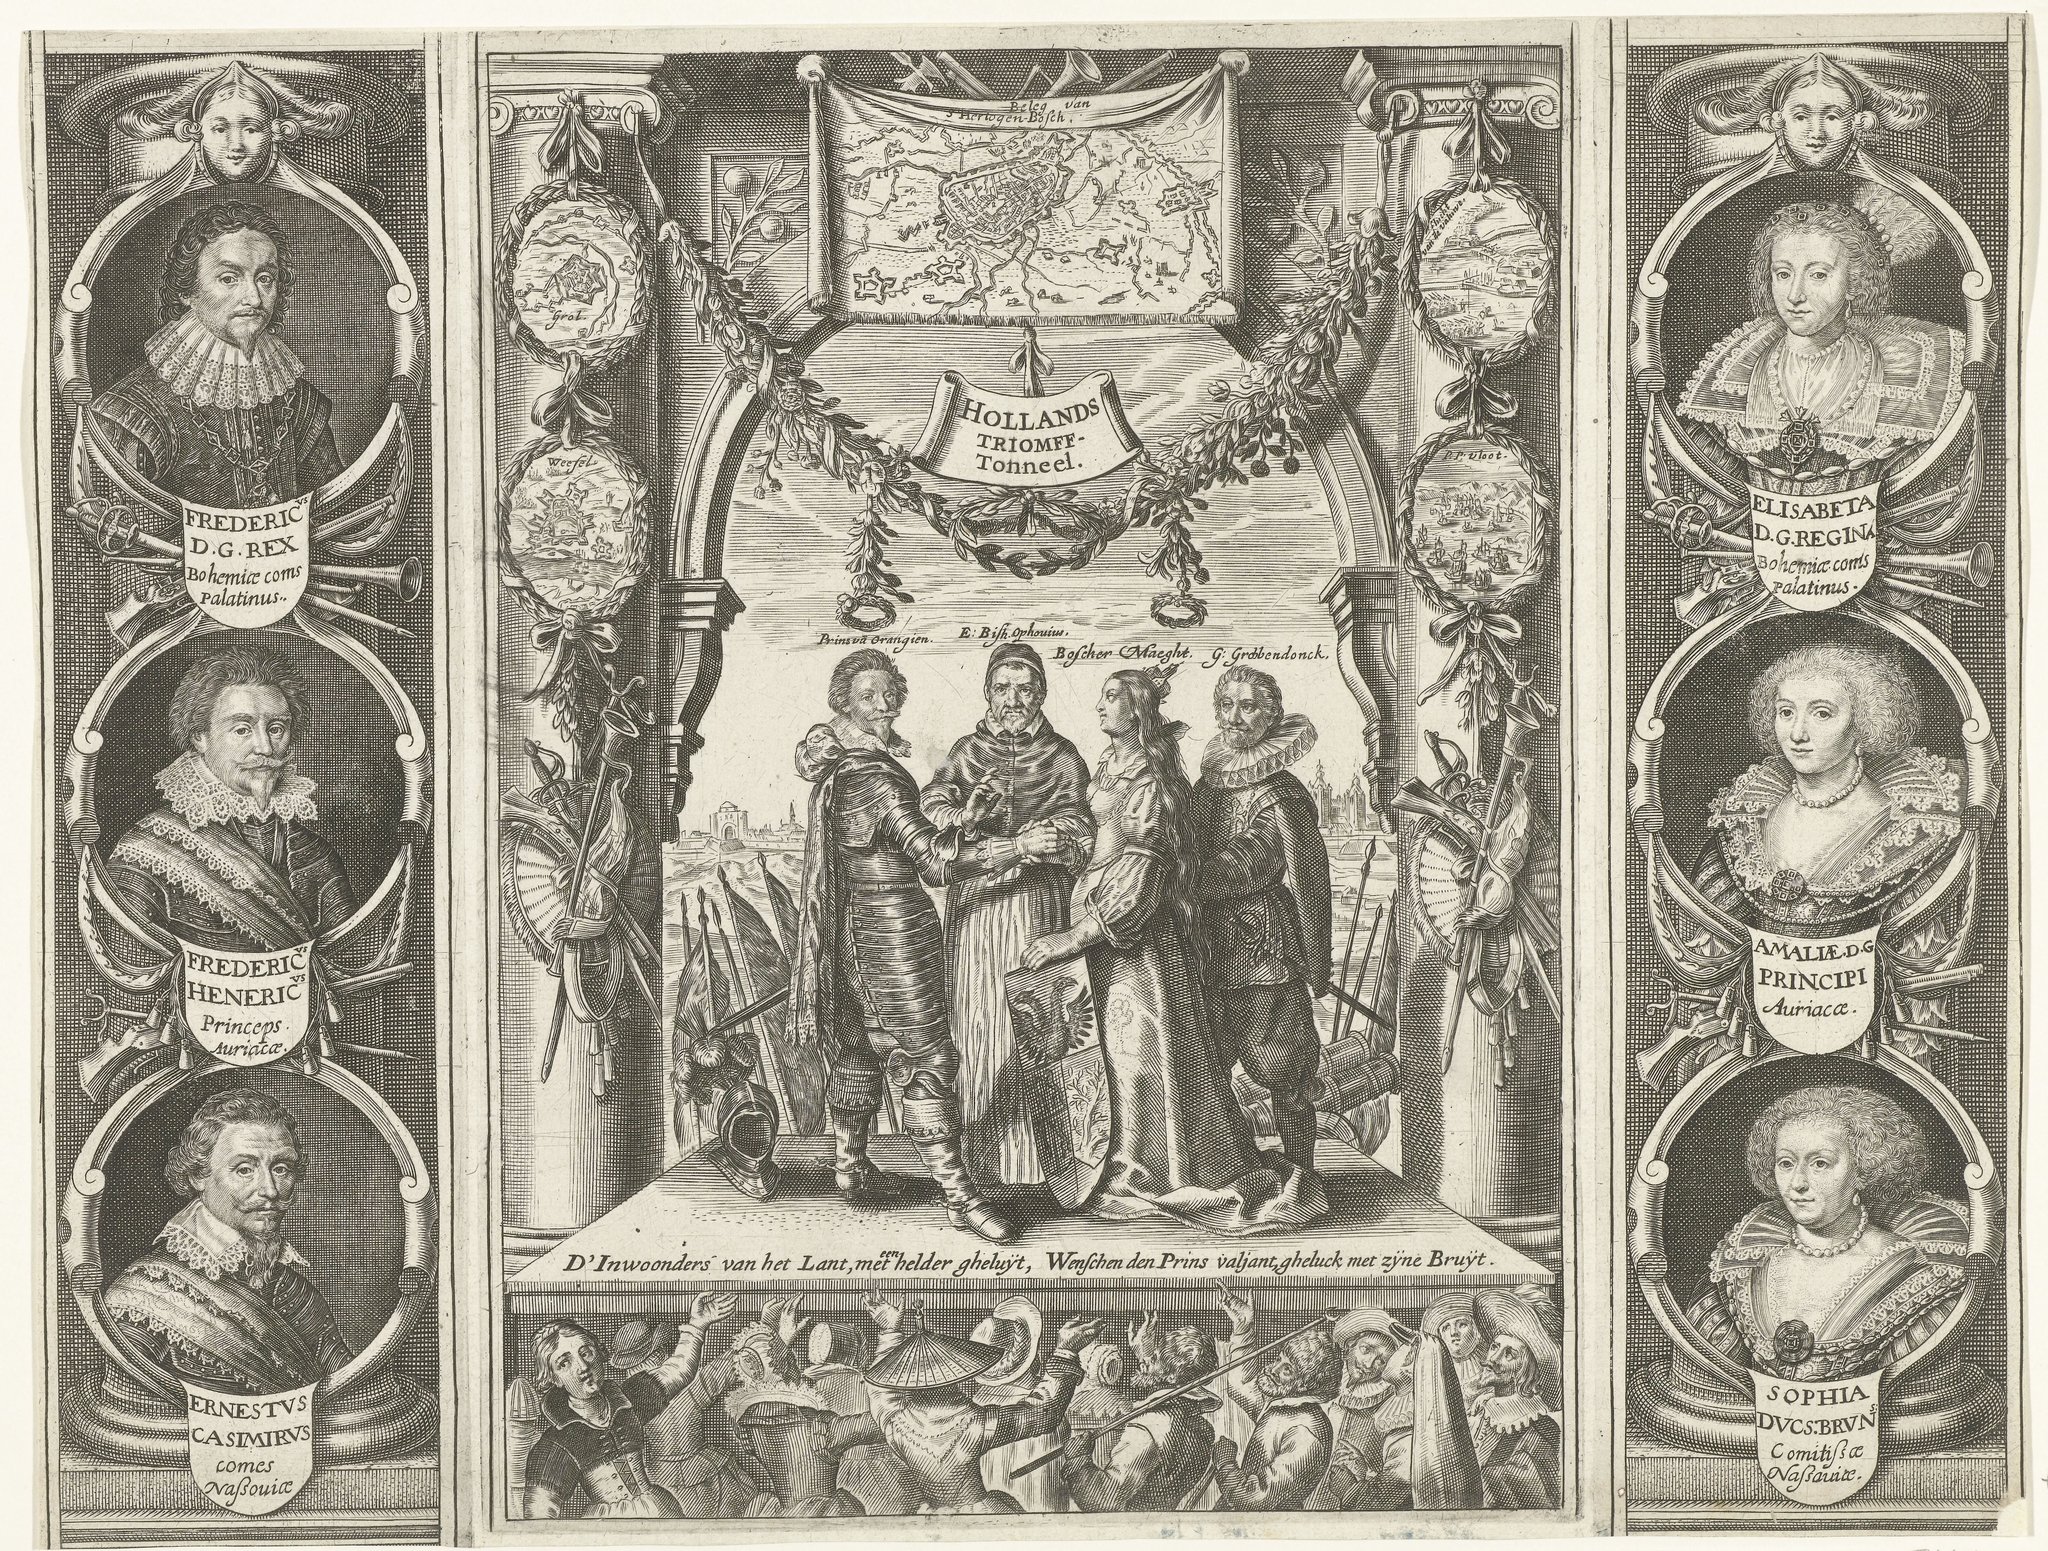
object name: print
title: Hollands Triomff-Tonneel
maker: crispijn van de passe (ii)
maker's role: draughtsman, print maker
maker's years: 1594-1670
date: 1629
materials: paper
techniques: engraving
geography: northern netherlands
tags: sophia hedwig van brunswijk-wolfenbüttel, delft, frederick henry (prince of orange), the hague, amalia of solms-braunfels, amberg, frederik v (keurvorst van de palts, koning van bohemen), london, ernst casimir graaf van nassau-dietz, anthonie schets baron van grobbendonck, den bosch, lierre, michael ophovius, civil marriage ceremony, capture of city (after the siege)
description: Allegorie op de verovering van 's-Hertogenbosch door Frederik Hendrik op 17 september 1629. Op een toneel wordt de stadhouder Frederik Hendrik door de bisschop Ophovius gehuwd met de stadsmaagd van Den Bosch. Achter de stadsmaagd staat gouverneur van Grobbendonck, als de vader van de bruid. De zuilen aan weerszijden van het toneel versierd met wapentuig en medaillons met eerdere militaire veroveringen onder het beleid van de stadhouder. Bovenaan hangt een doek met een kaart van het beleg van Den Bosch. Links portretten van paltsgraaf Frederik van Bohemen, Frederik Hendrik en Ernst Casimir, rechts de portretten van hun echtgenoten. Geheel gedrukt van drie platen.